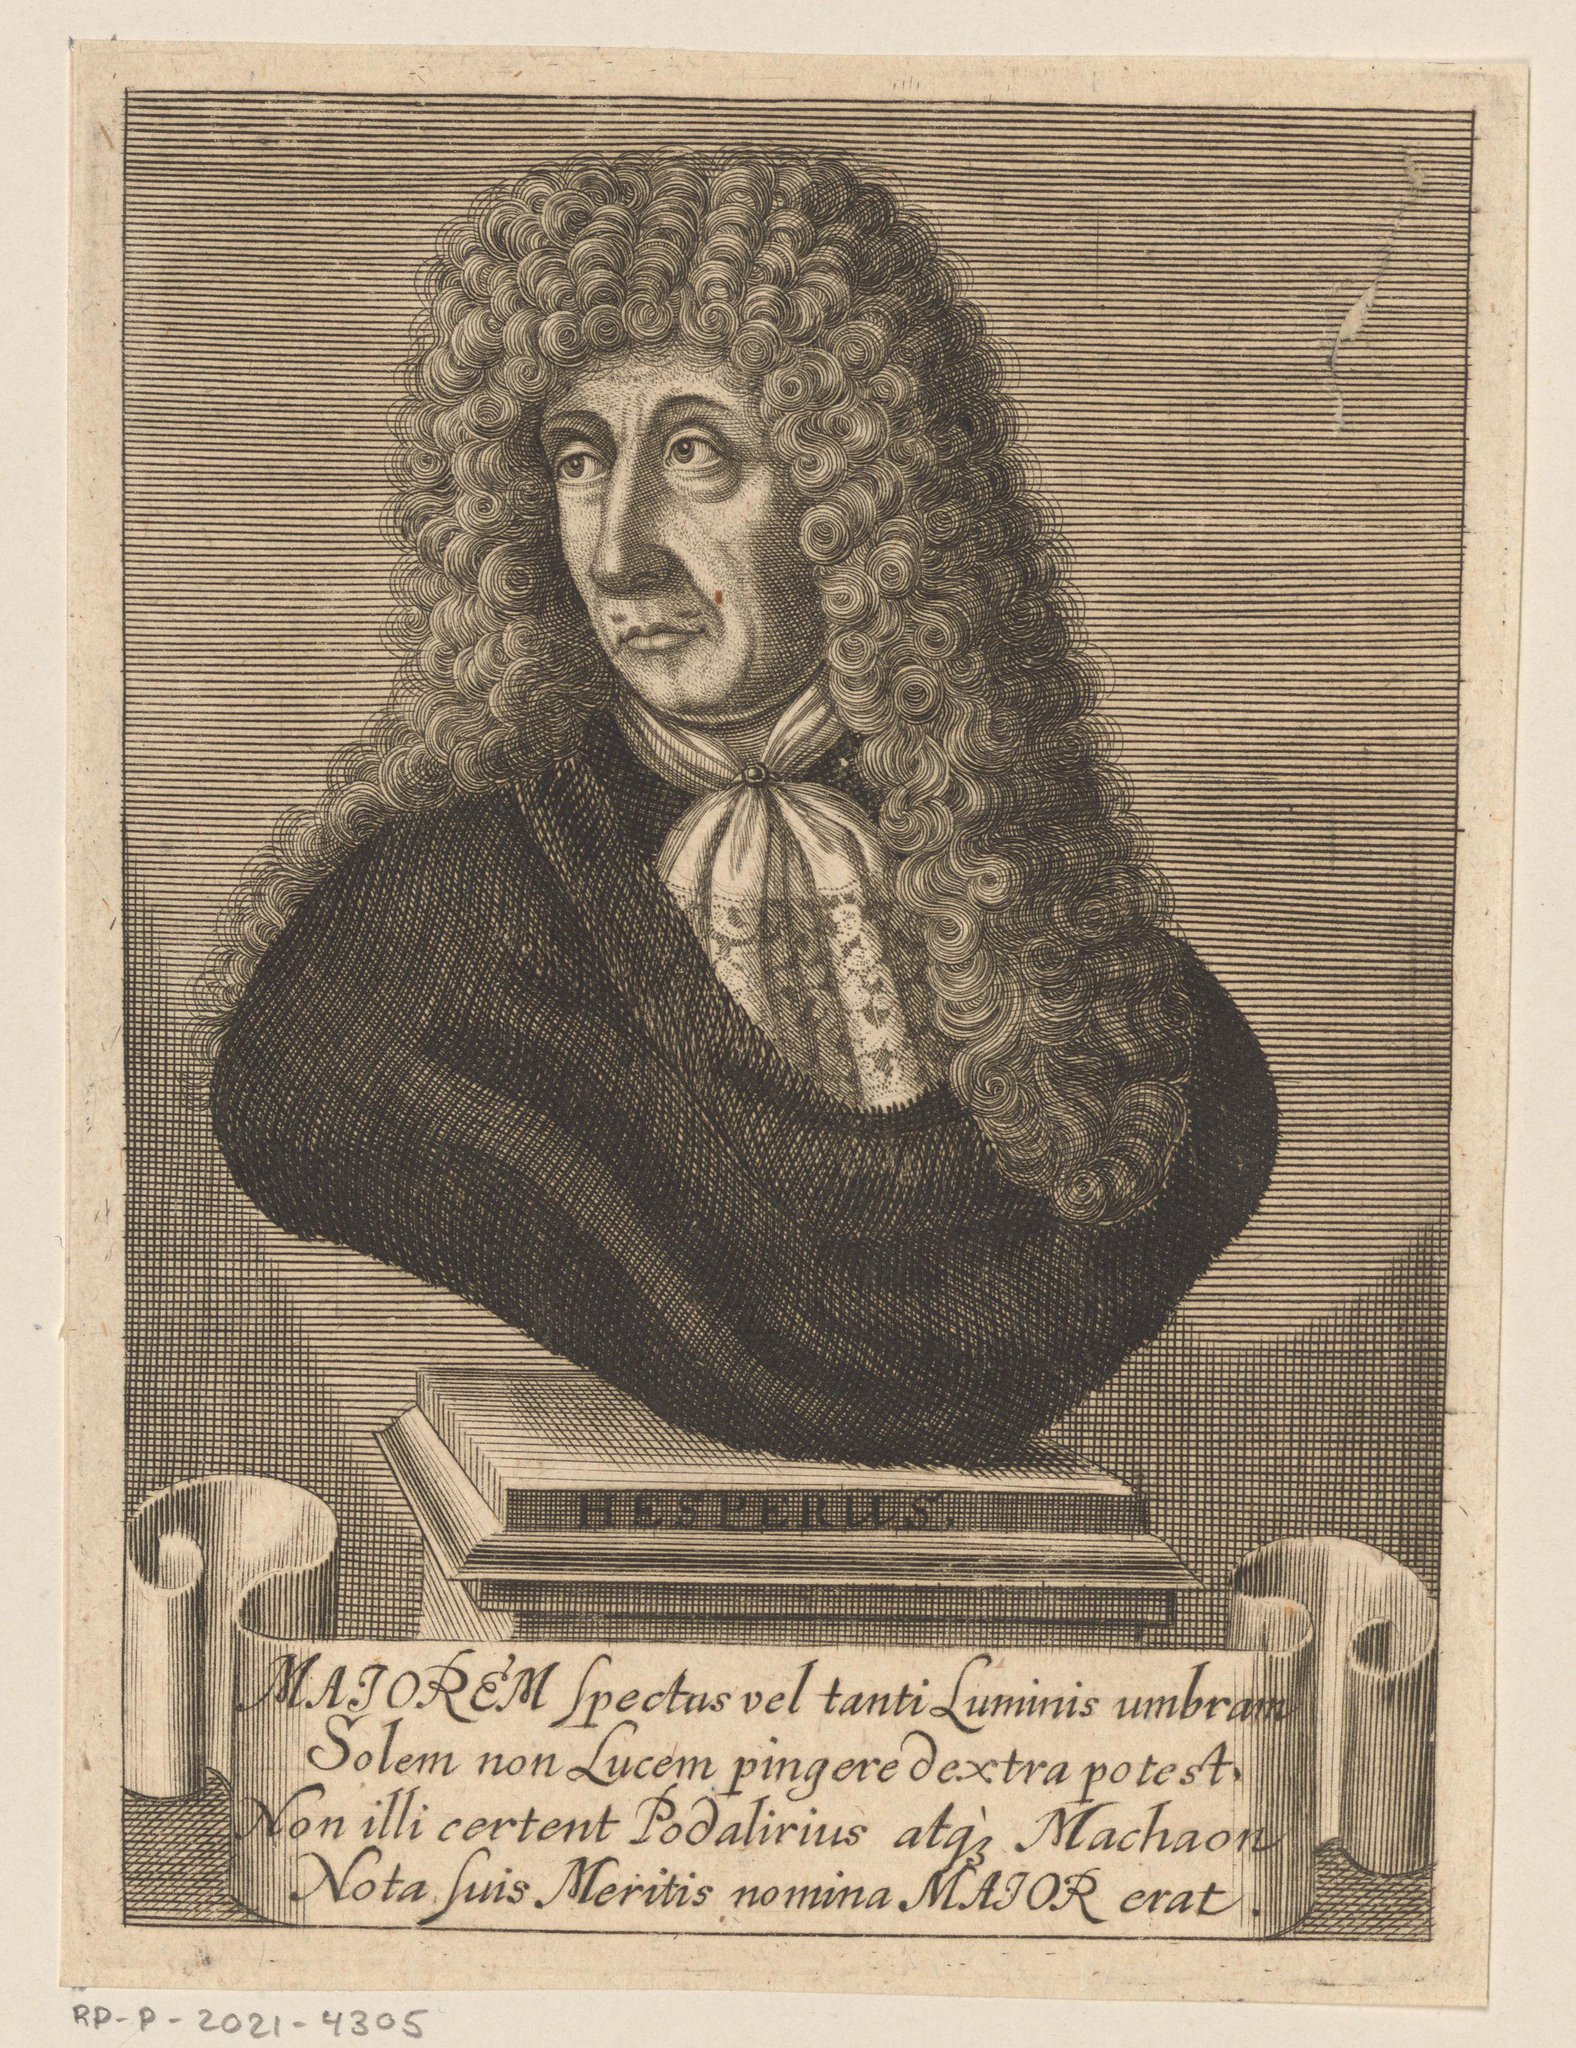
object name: print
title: Portret van Hesperus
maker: Anonymous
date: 1675-1749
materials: paper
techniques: engraving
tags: historical persons